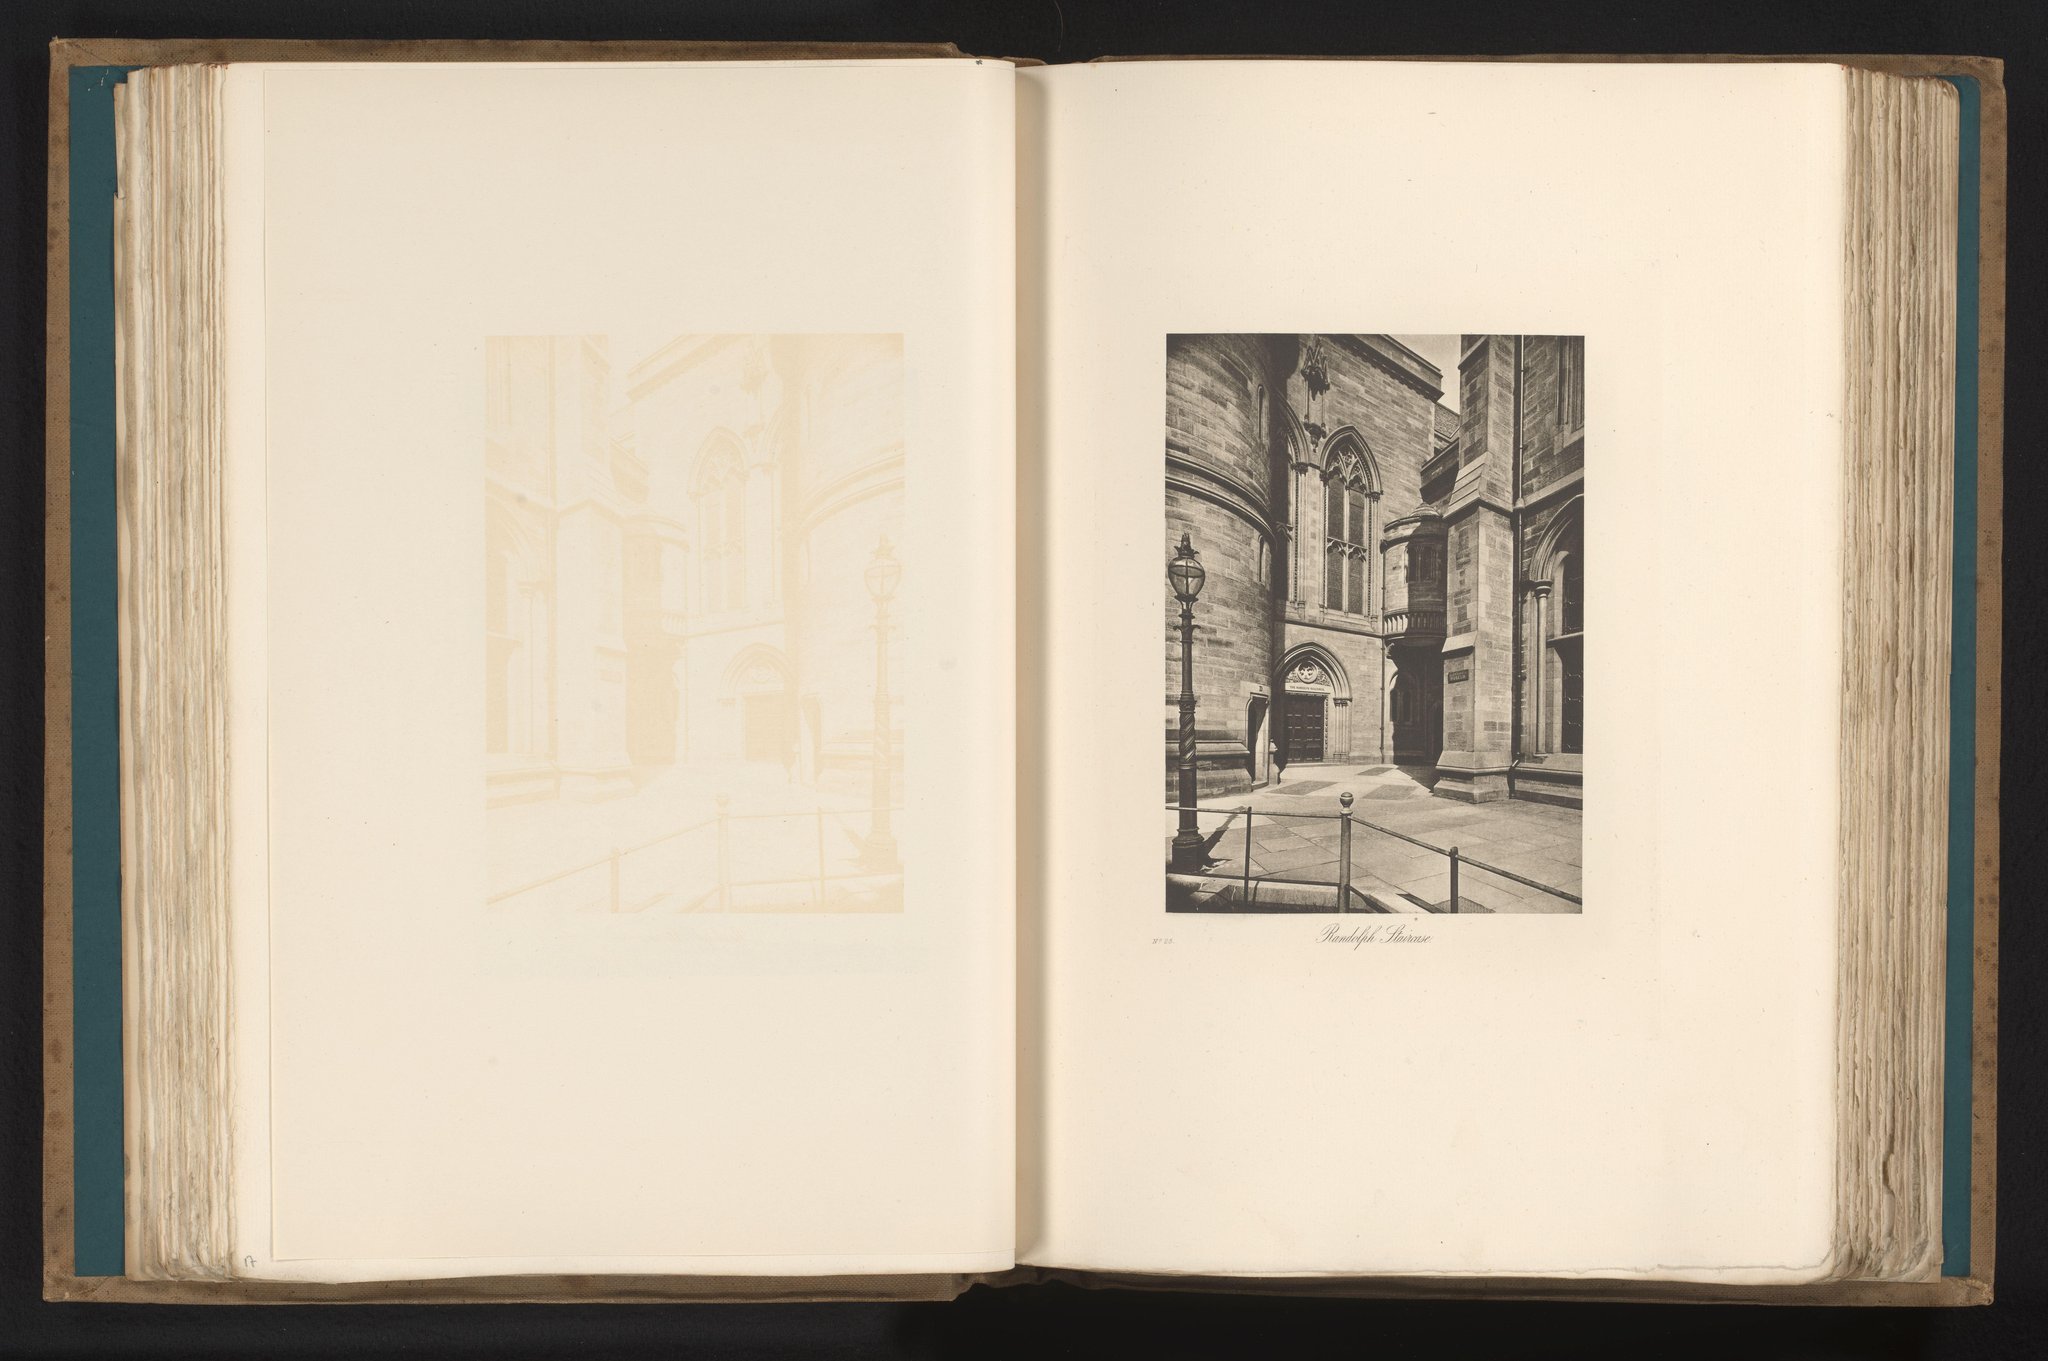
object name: photomechanical print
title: Entree van de Randolph Hall van de universiteit van Glasgow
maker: Anonymous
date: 1886-1891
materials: paper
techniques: photoaquatint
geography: glasgow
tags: university (+ building ~ education, tuition), gate, entrance, glasgow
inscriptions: inscription: ‘No.25’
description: Prent op zestiende ongenummerde pagina na pagina xxxiii.